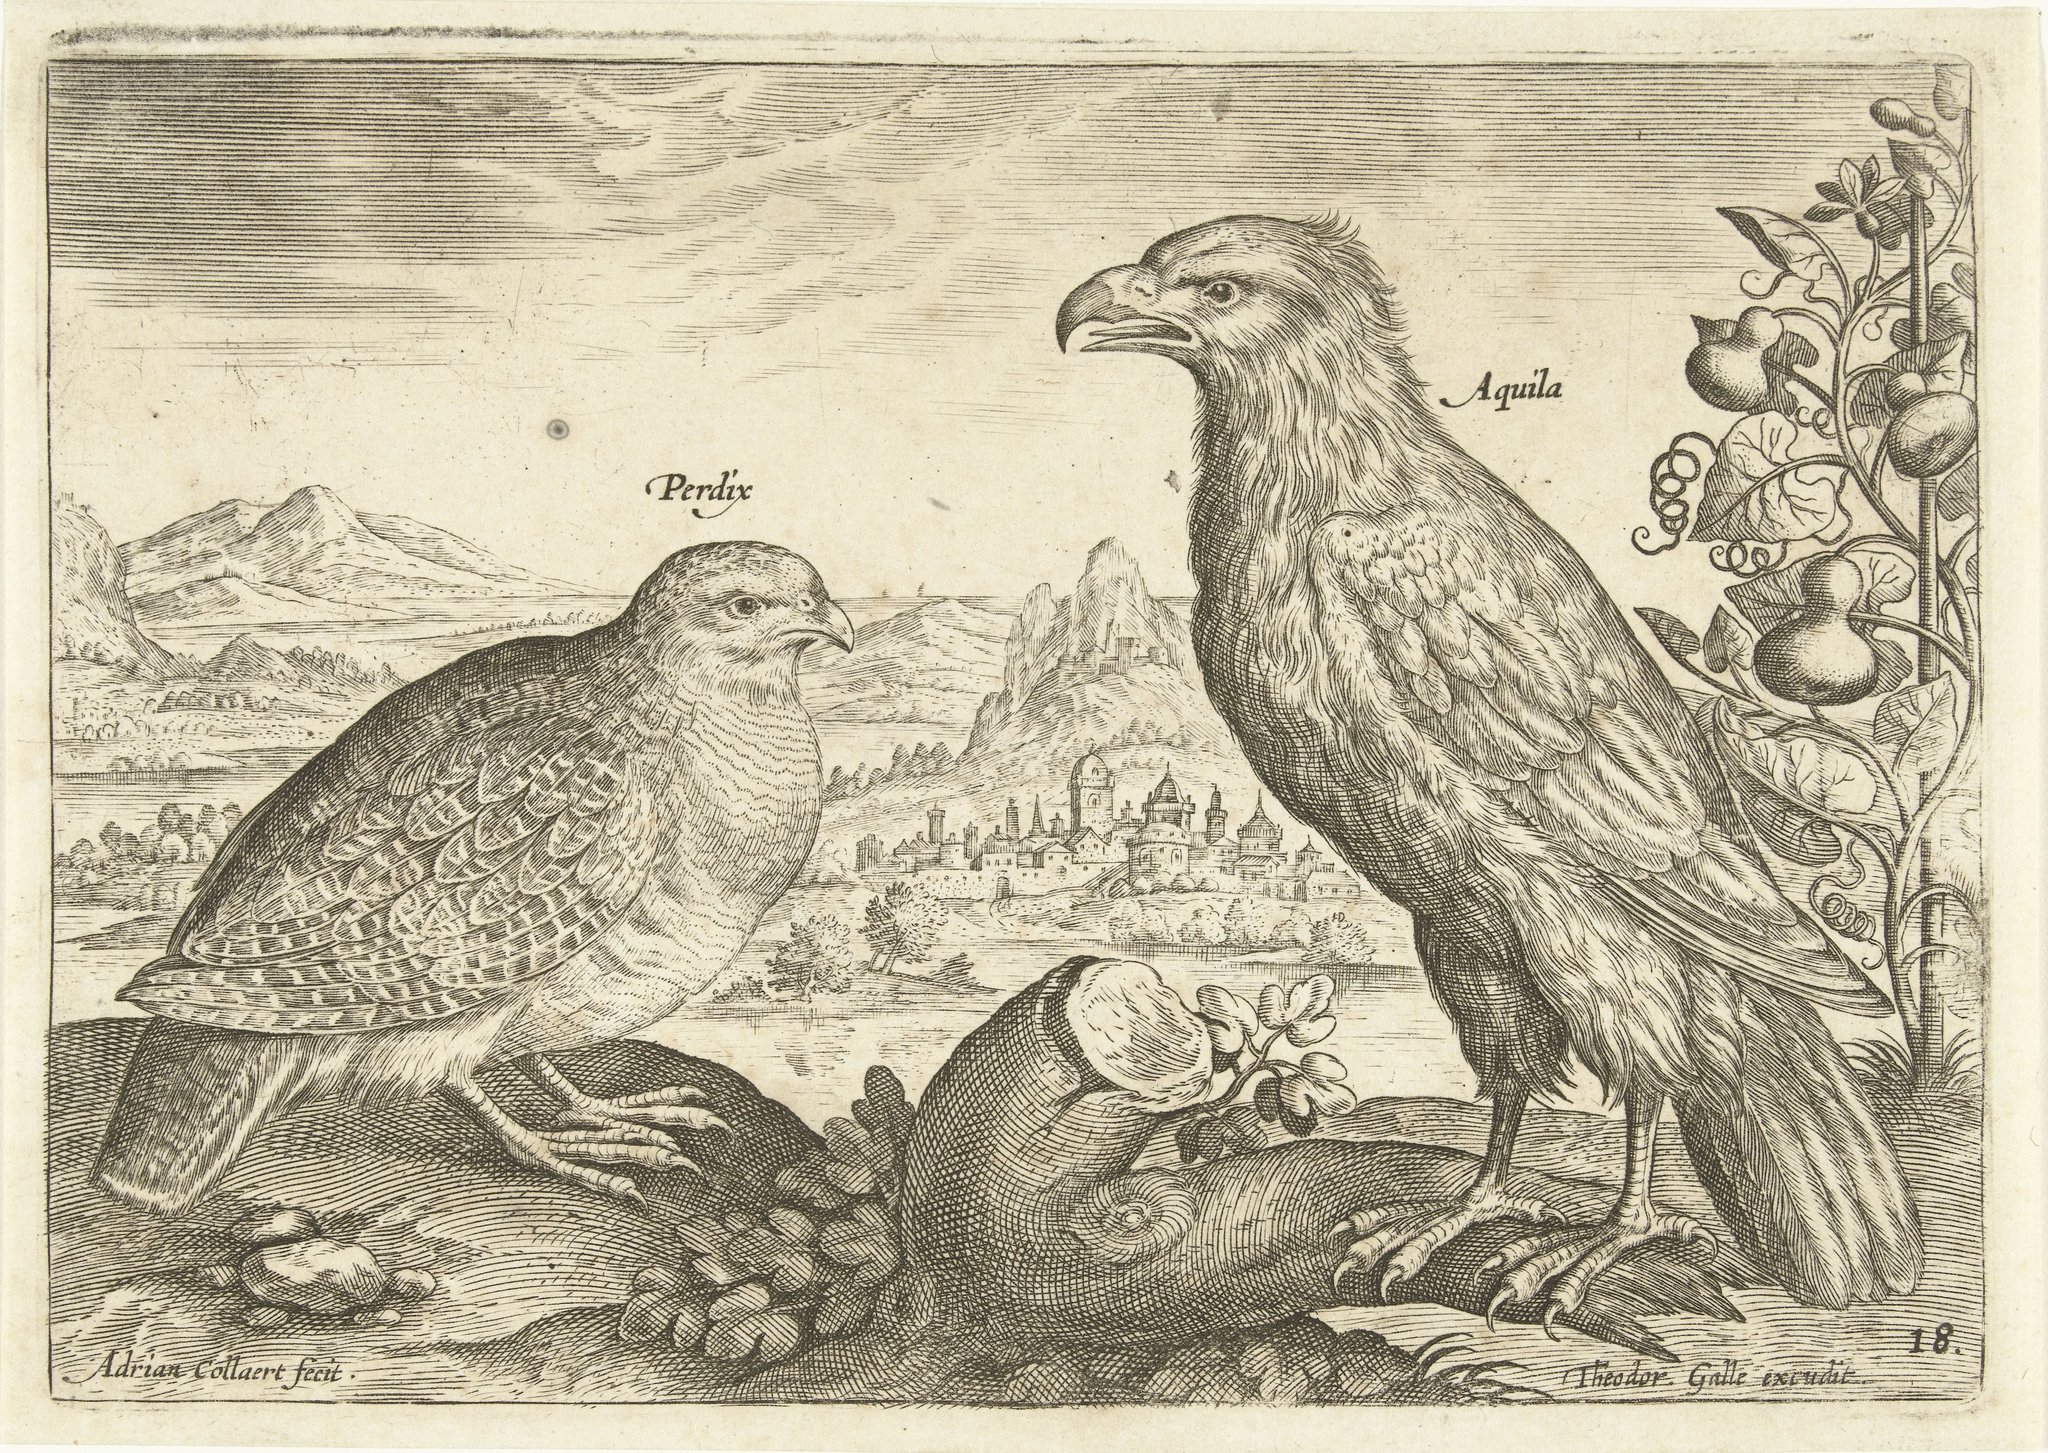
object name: print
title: Avivm Vivae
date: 1598-1618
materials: paper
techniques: engraving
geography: antwerp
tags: predatory birds: eagle, river, walker and runner birds: partridge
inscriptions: collector's mark: Lugt 2228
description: Een patrijs en een adelaar in een landschap. De prent maakt deel uit van een serie met vogels als onderwerp.